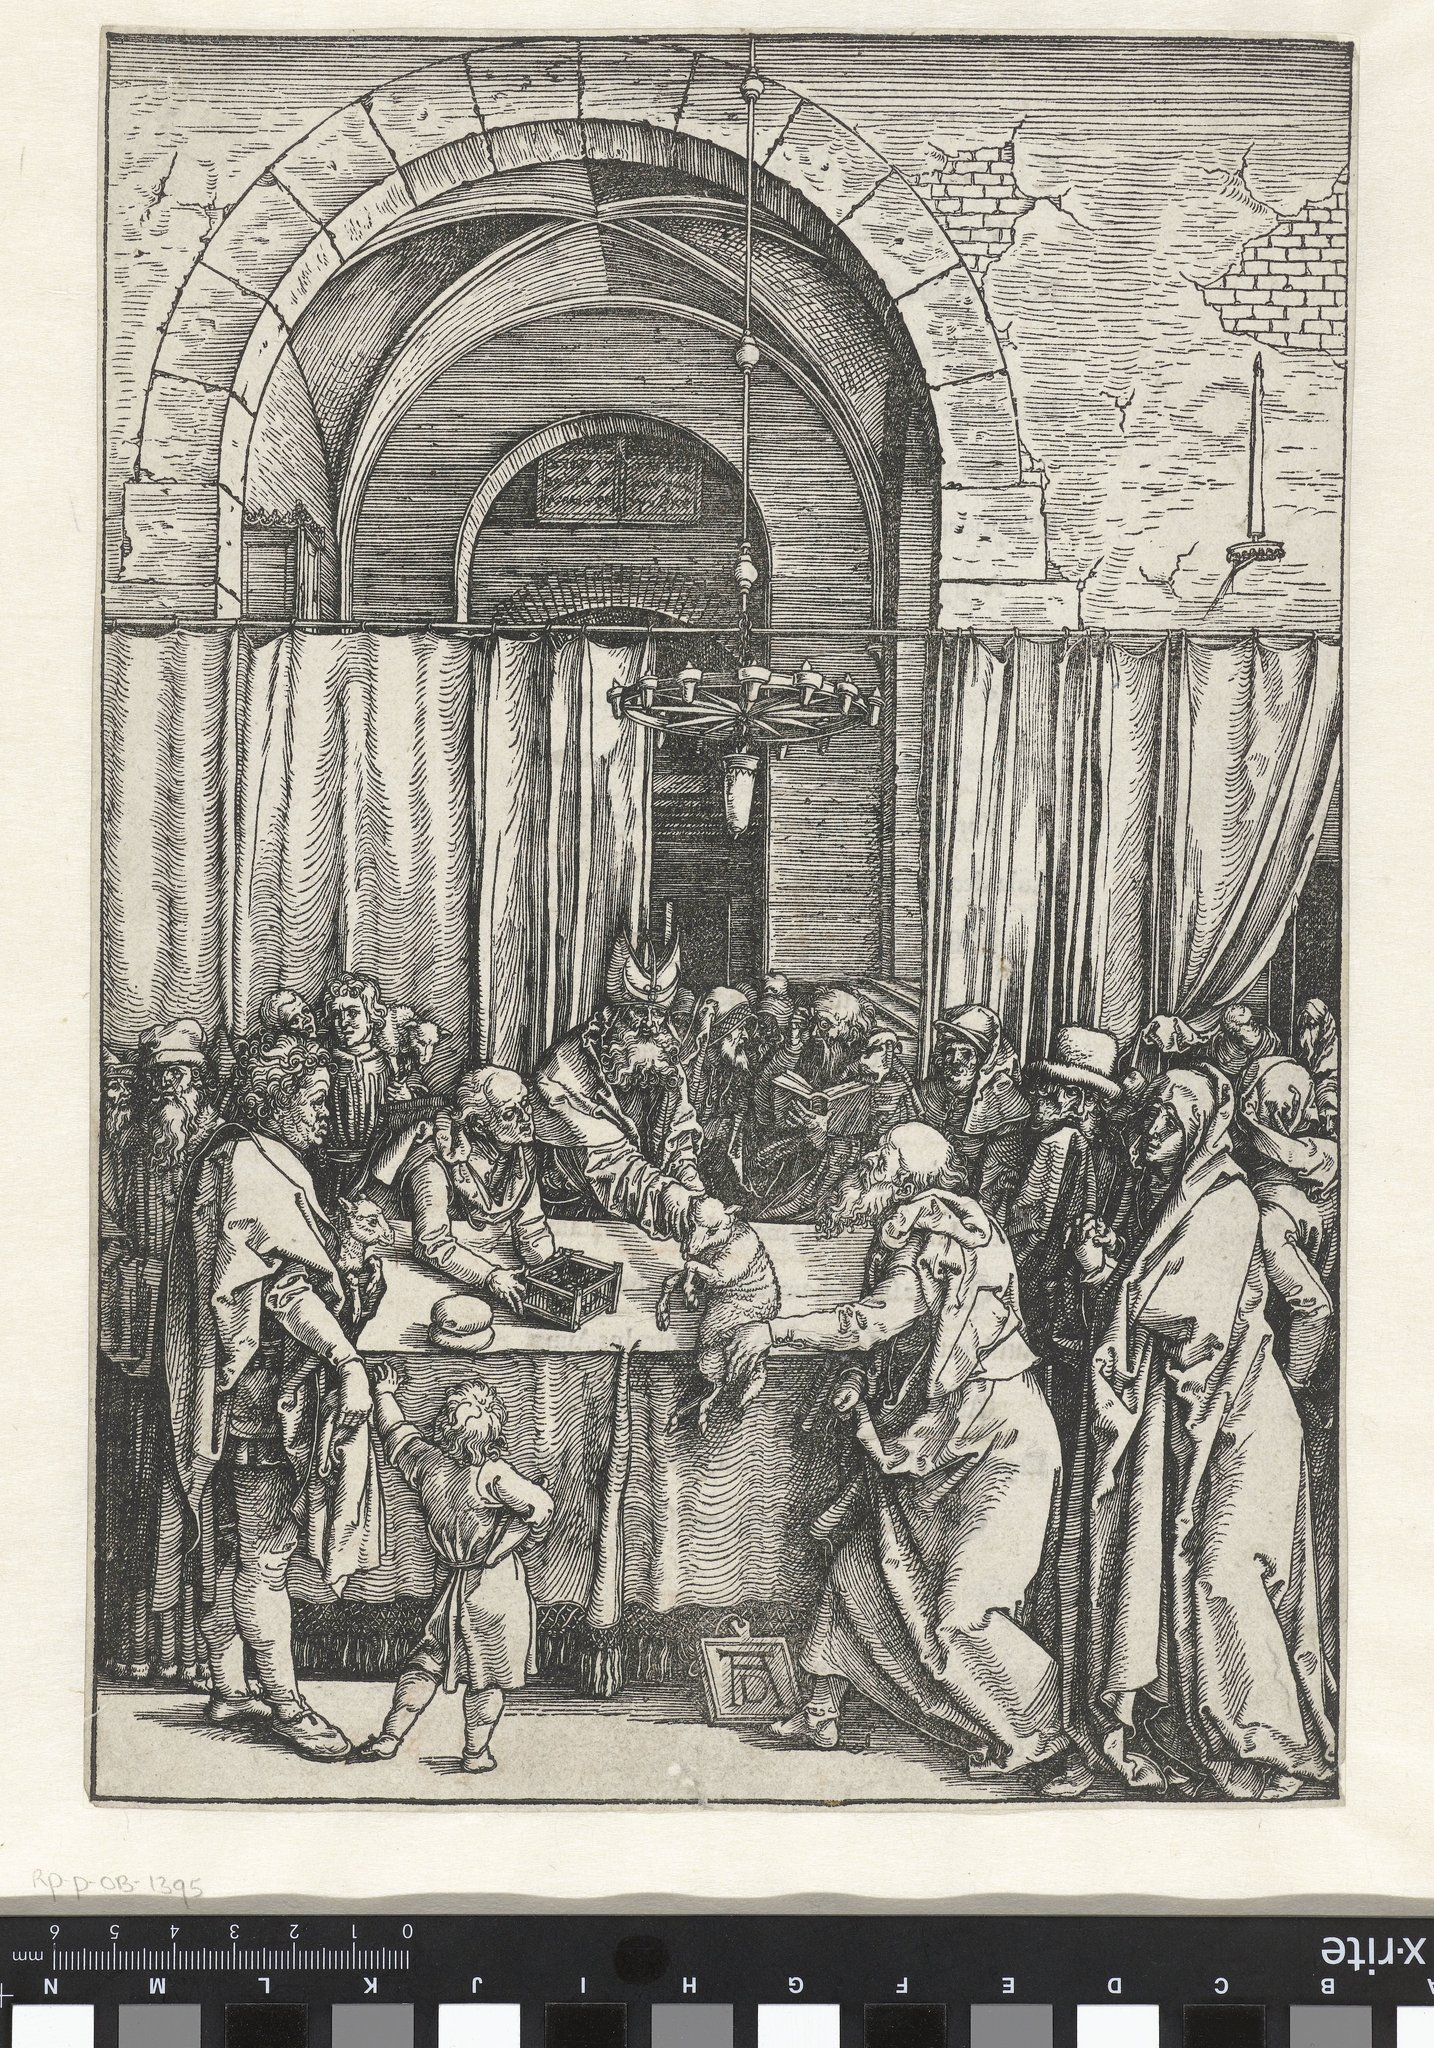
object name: print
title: Leven van Maria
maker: albrecht dürer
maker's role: draughtsman, painter, print maker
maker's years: 1471-1528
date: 1502-1506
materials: paper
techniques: letterpress printing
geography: nuremberg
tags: joachim's and anna's sacrifice refused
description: Joachim staat met Anna bij een tafel, waaromheen veel mensen staan. De hogepriester achter de tafel duwt het lam dat Joachim aanbiedt van de tafel af. Op versozijde gedrukte Latijnse tekst. Deze prent is onderdeel van een serie van 20 prenten, bestaand uit een titelprent en 19 prenten met scènes uit het leven van Maria.